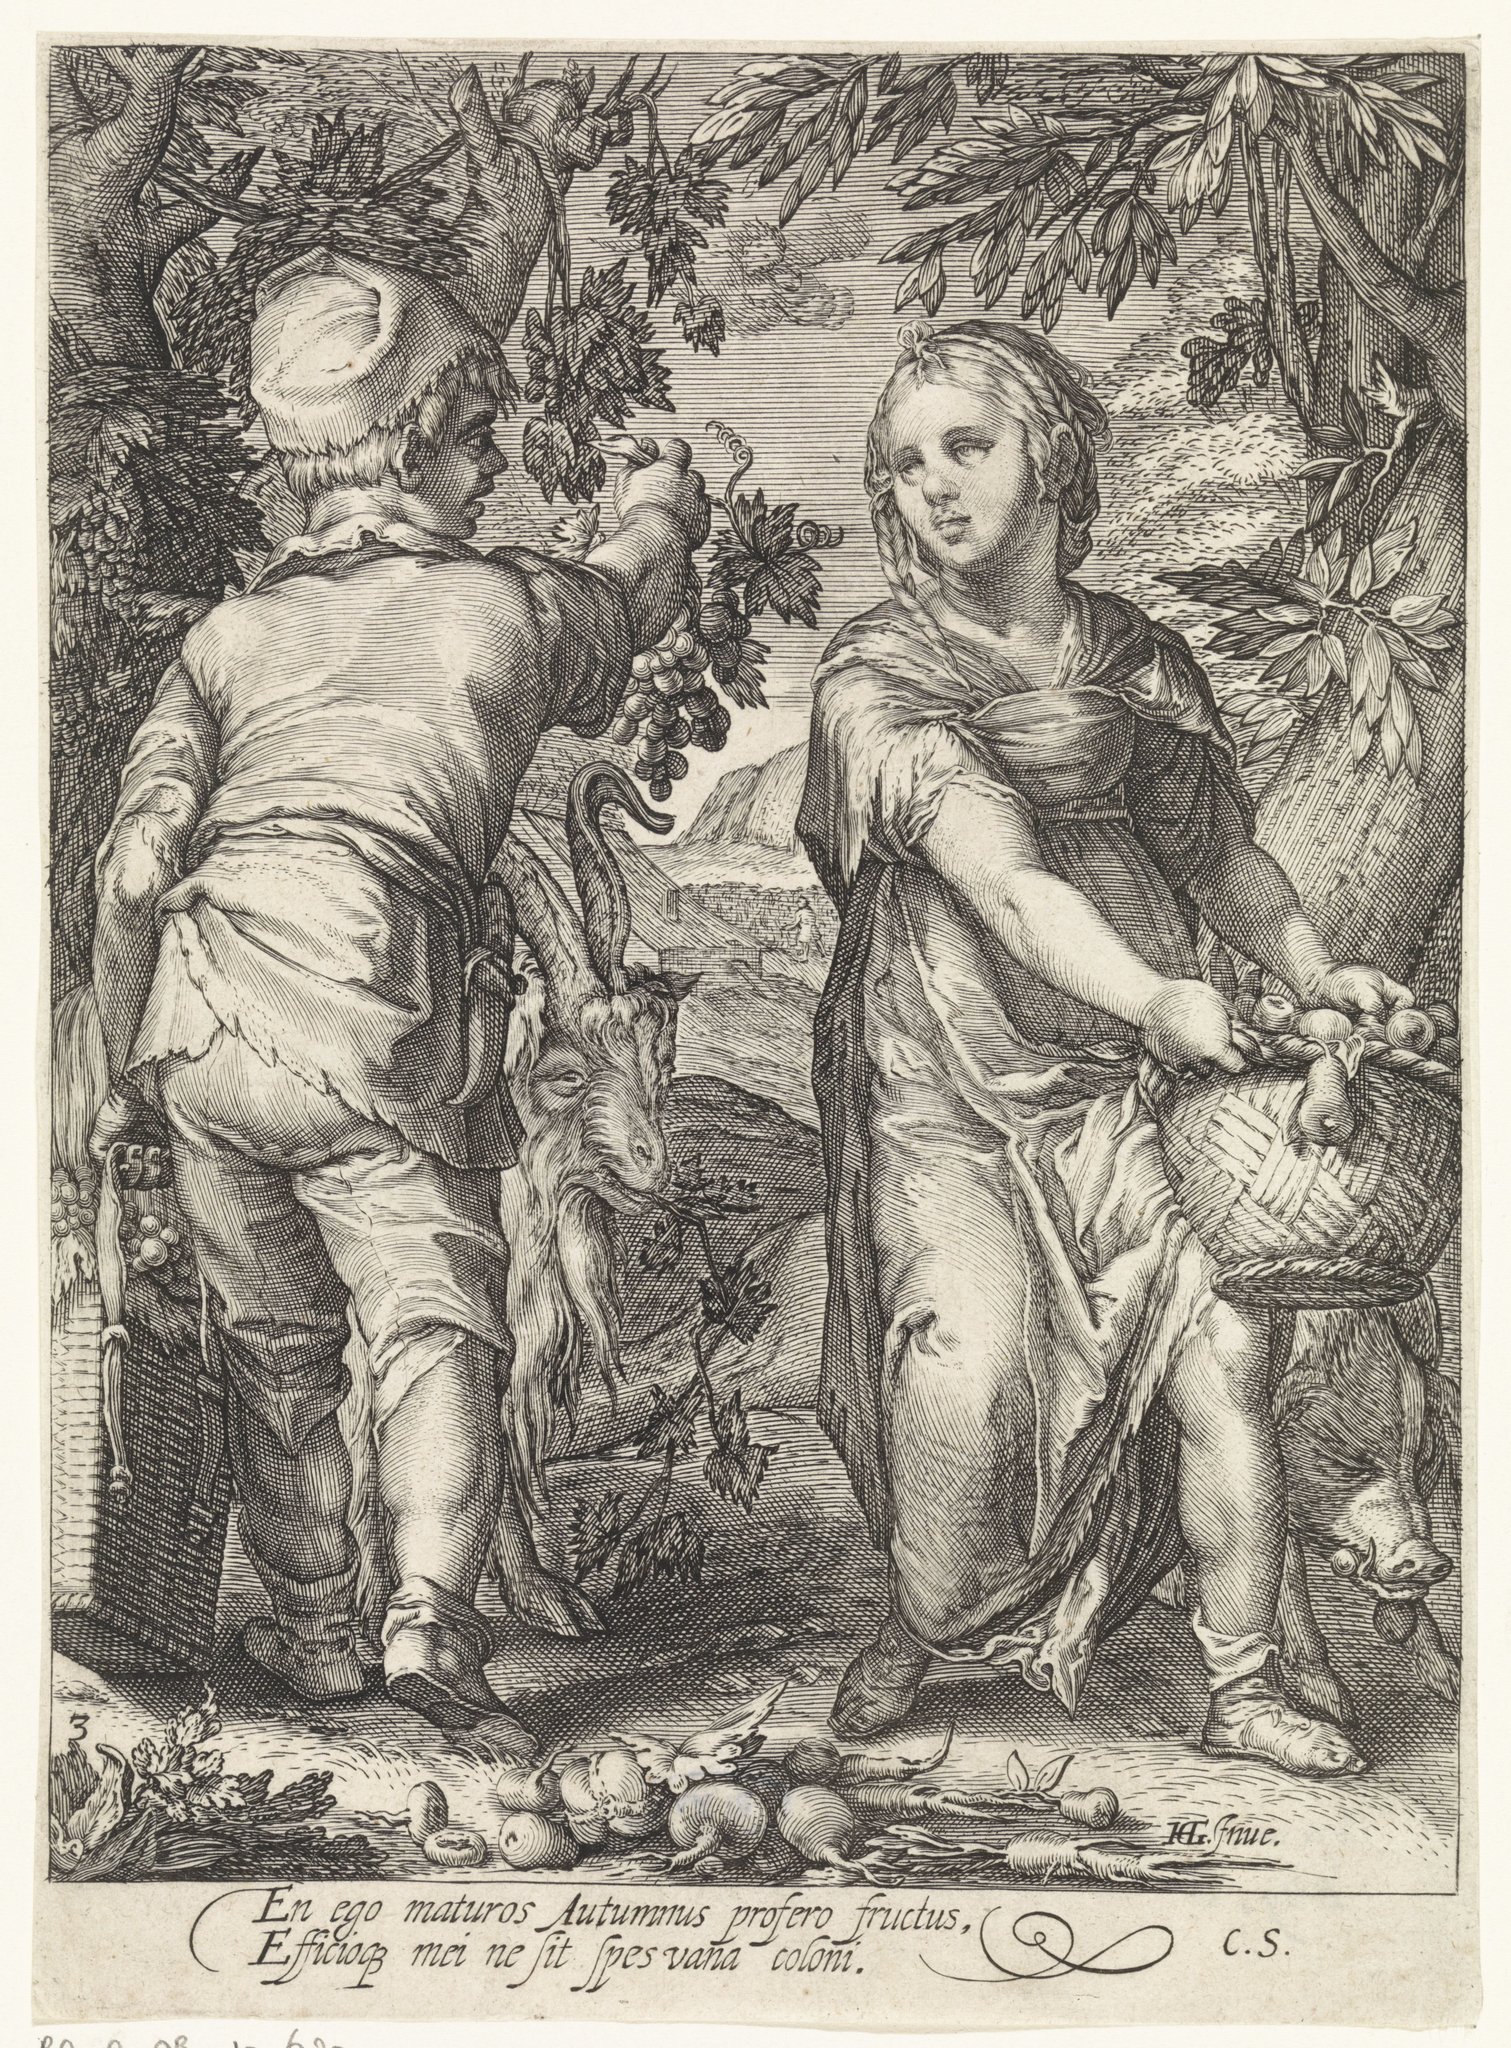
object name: print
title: De vier seizoenen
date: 1601-1651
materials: paper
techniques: engraving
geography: northern netherlands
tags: fruit-tree culture; fruit harvest, boar (male pig), he-goat, billy-goat, vintage, grape harvest, autumn, fall, 'autumnus'; 'autunno' (ripa)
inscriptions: collector's mark: Lugt 2228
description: Een jongen en een meisje oogsten fruit in het bijzijn van een bok en een zwijn. De jongen plukt druiven, het meisje draagt een mand met peren.